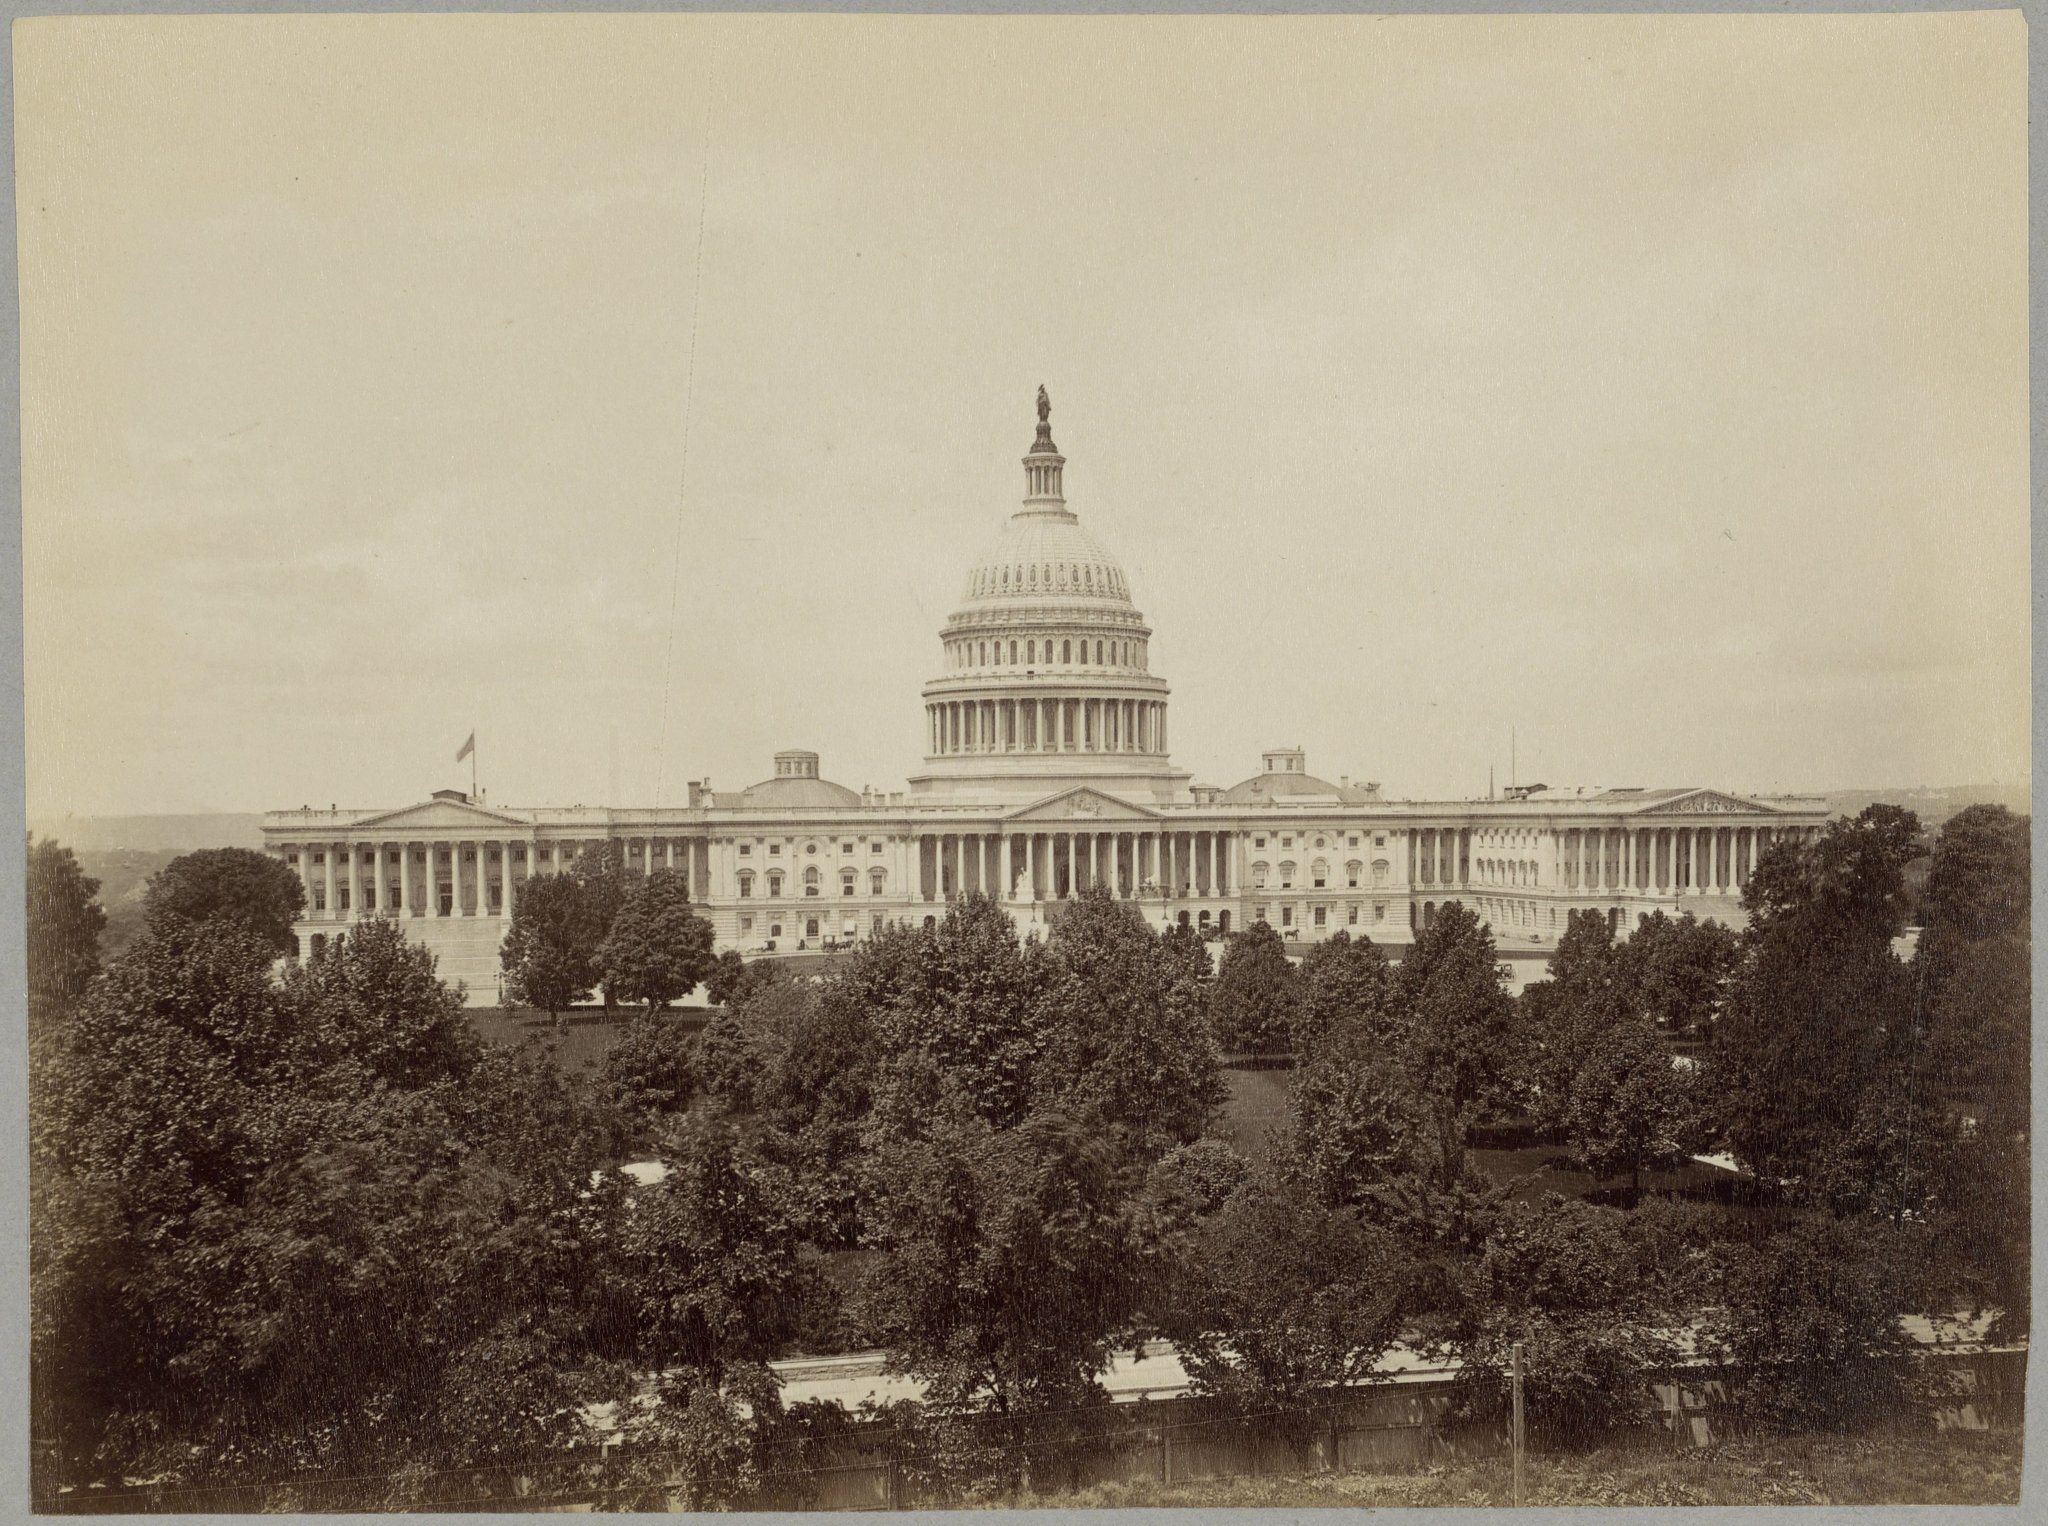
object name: photograph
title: Gezicht op de oostzijde en de koepel van het Capitool in Washington D.C.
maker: Anonymous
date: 1880-1900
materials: cardboard, paper, photographic support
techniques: albumen print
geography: washington d.c.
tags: dome ~ architecture